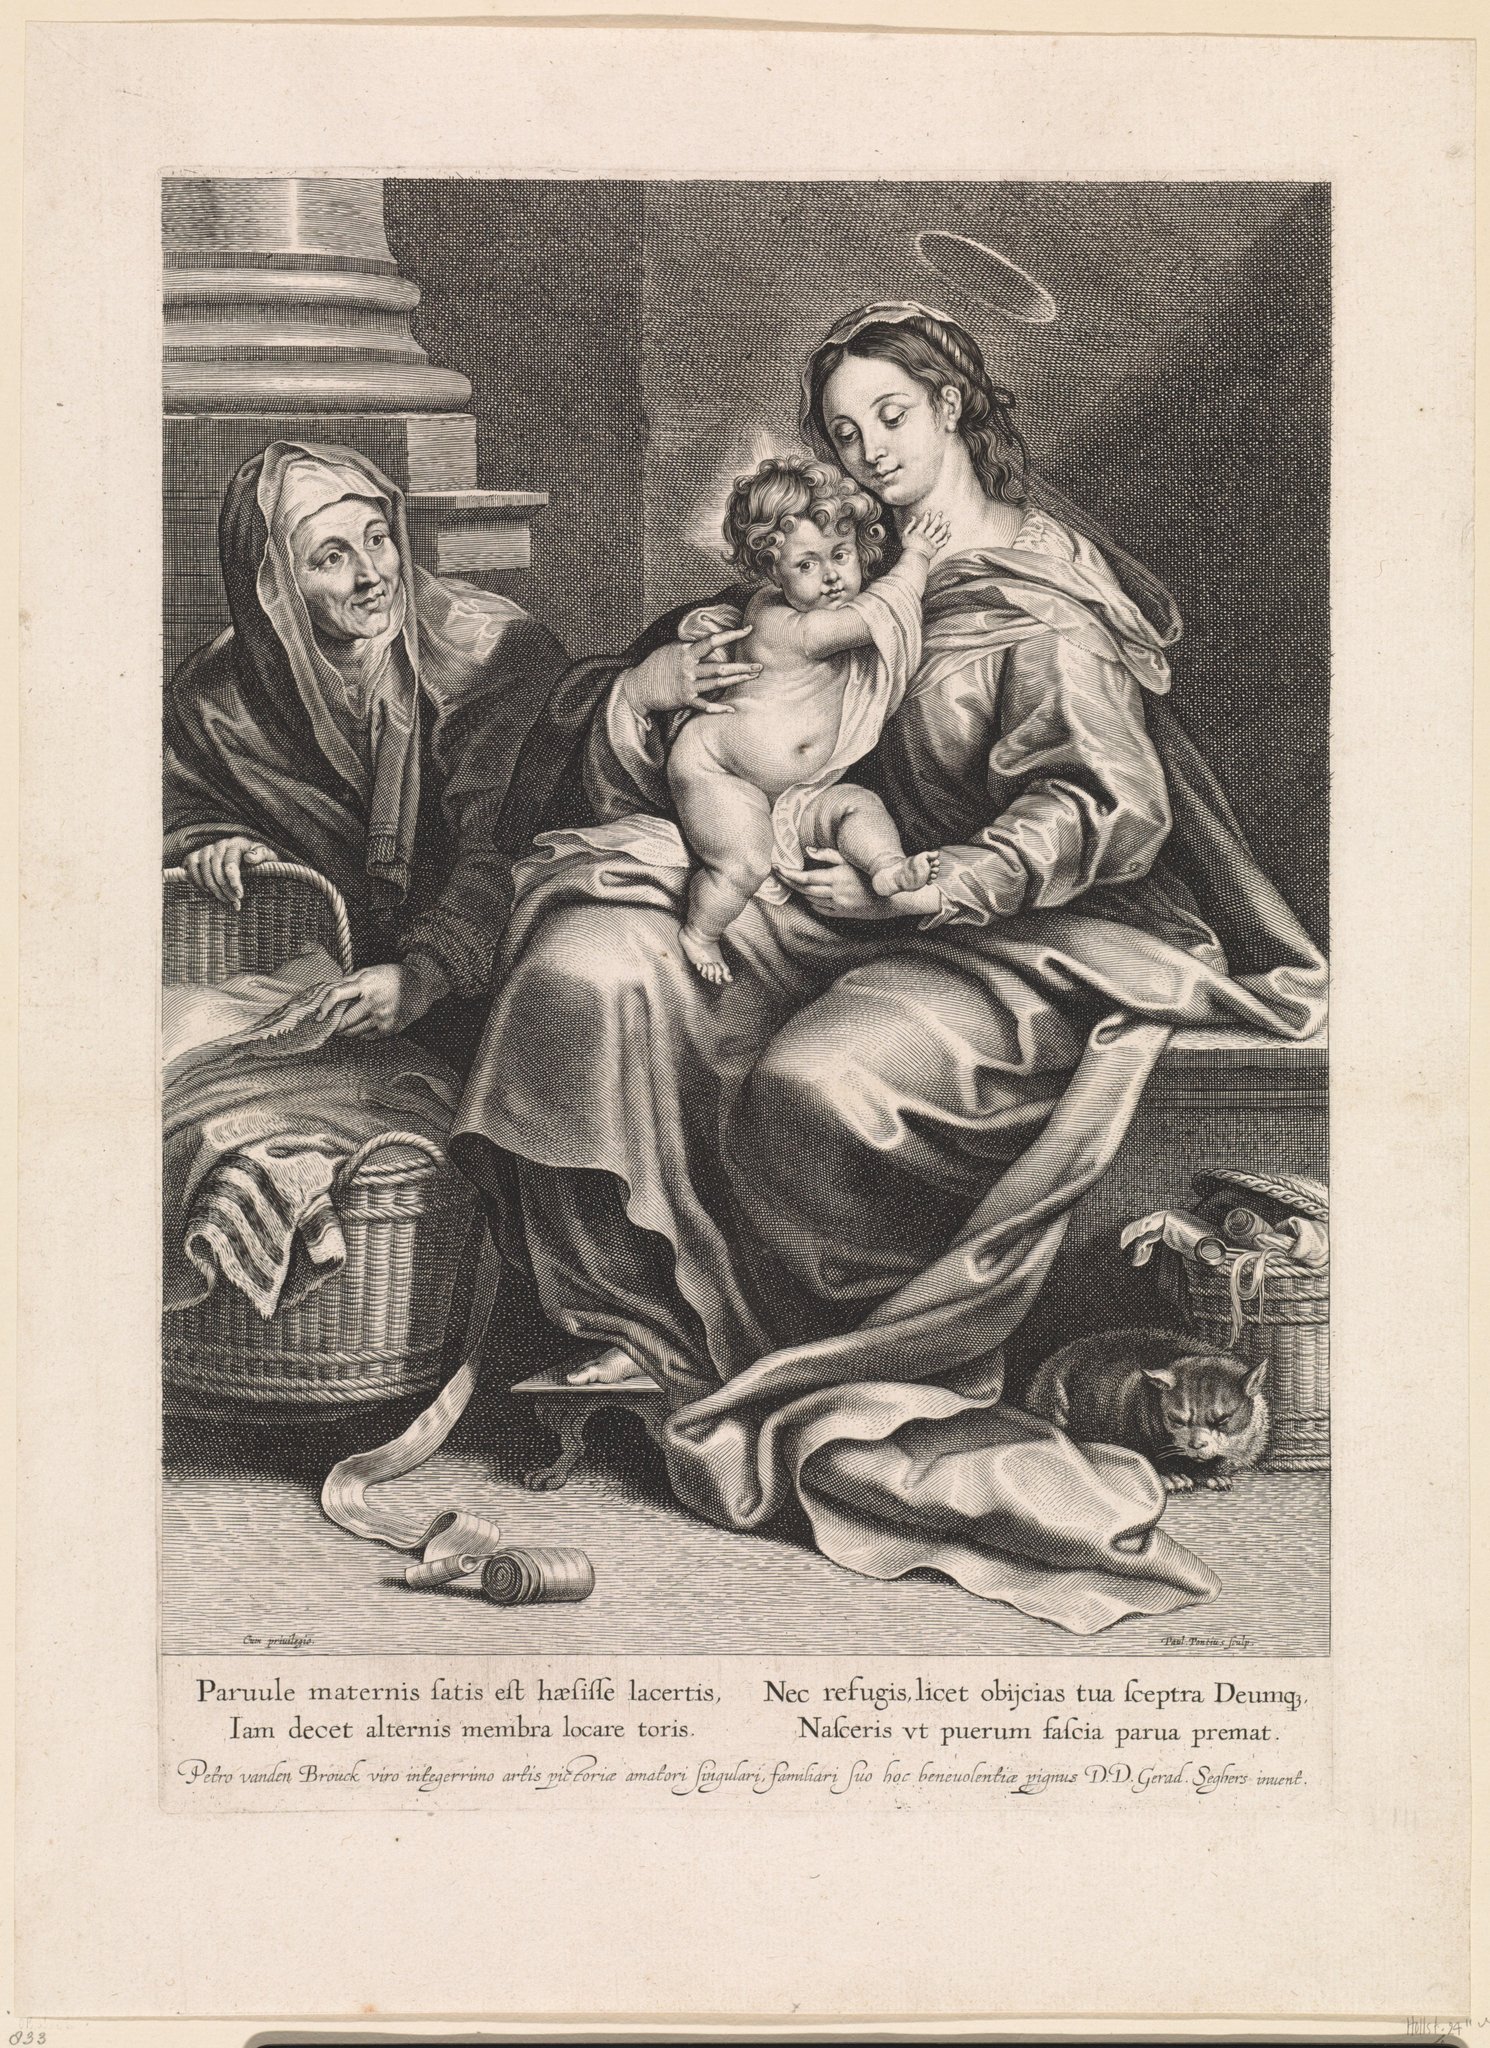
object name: print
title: Anna te Drieën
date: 1616-1657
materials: paper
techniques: engraving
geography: antwerp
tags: 'anna selbdritt', i.e. anna, mary and christ-child close together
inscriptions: collector's mark: Lugt 240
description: Maria zit met het Christuskind op schoot. Links naast hen buigt Anna zich over de wieg. In de marge een vierregelig onderschrift, in twee kolommen, in het Latijn.